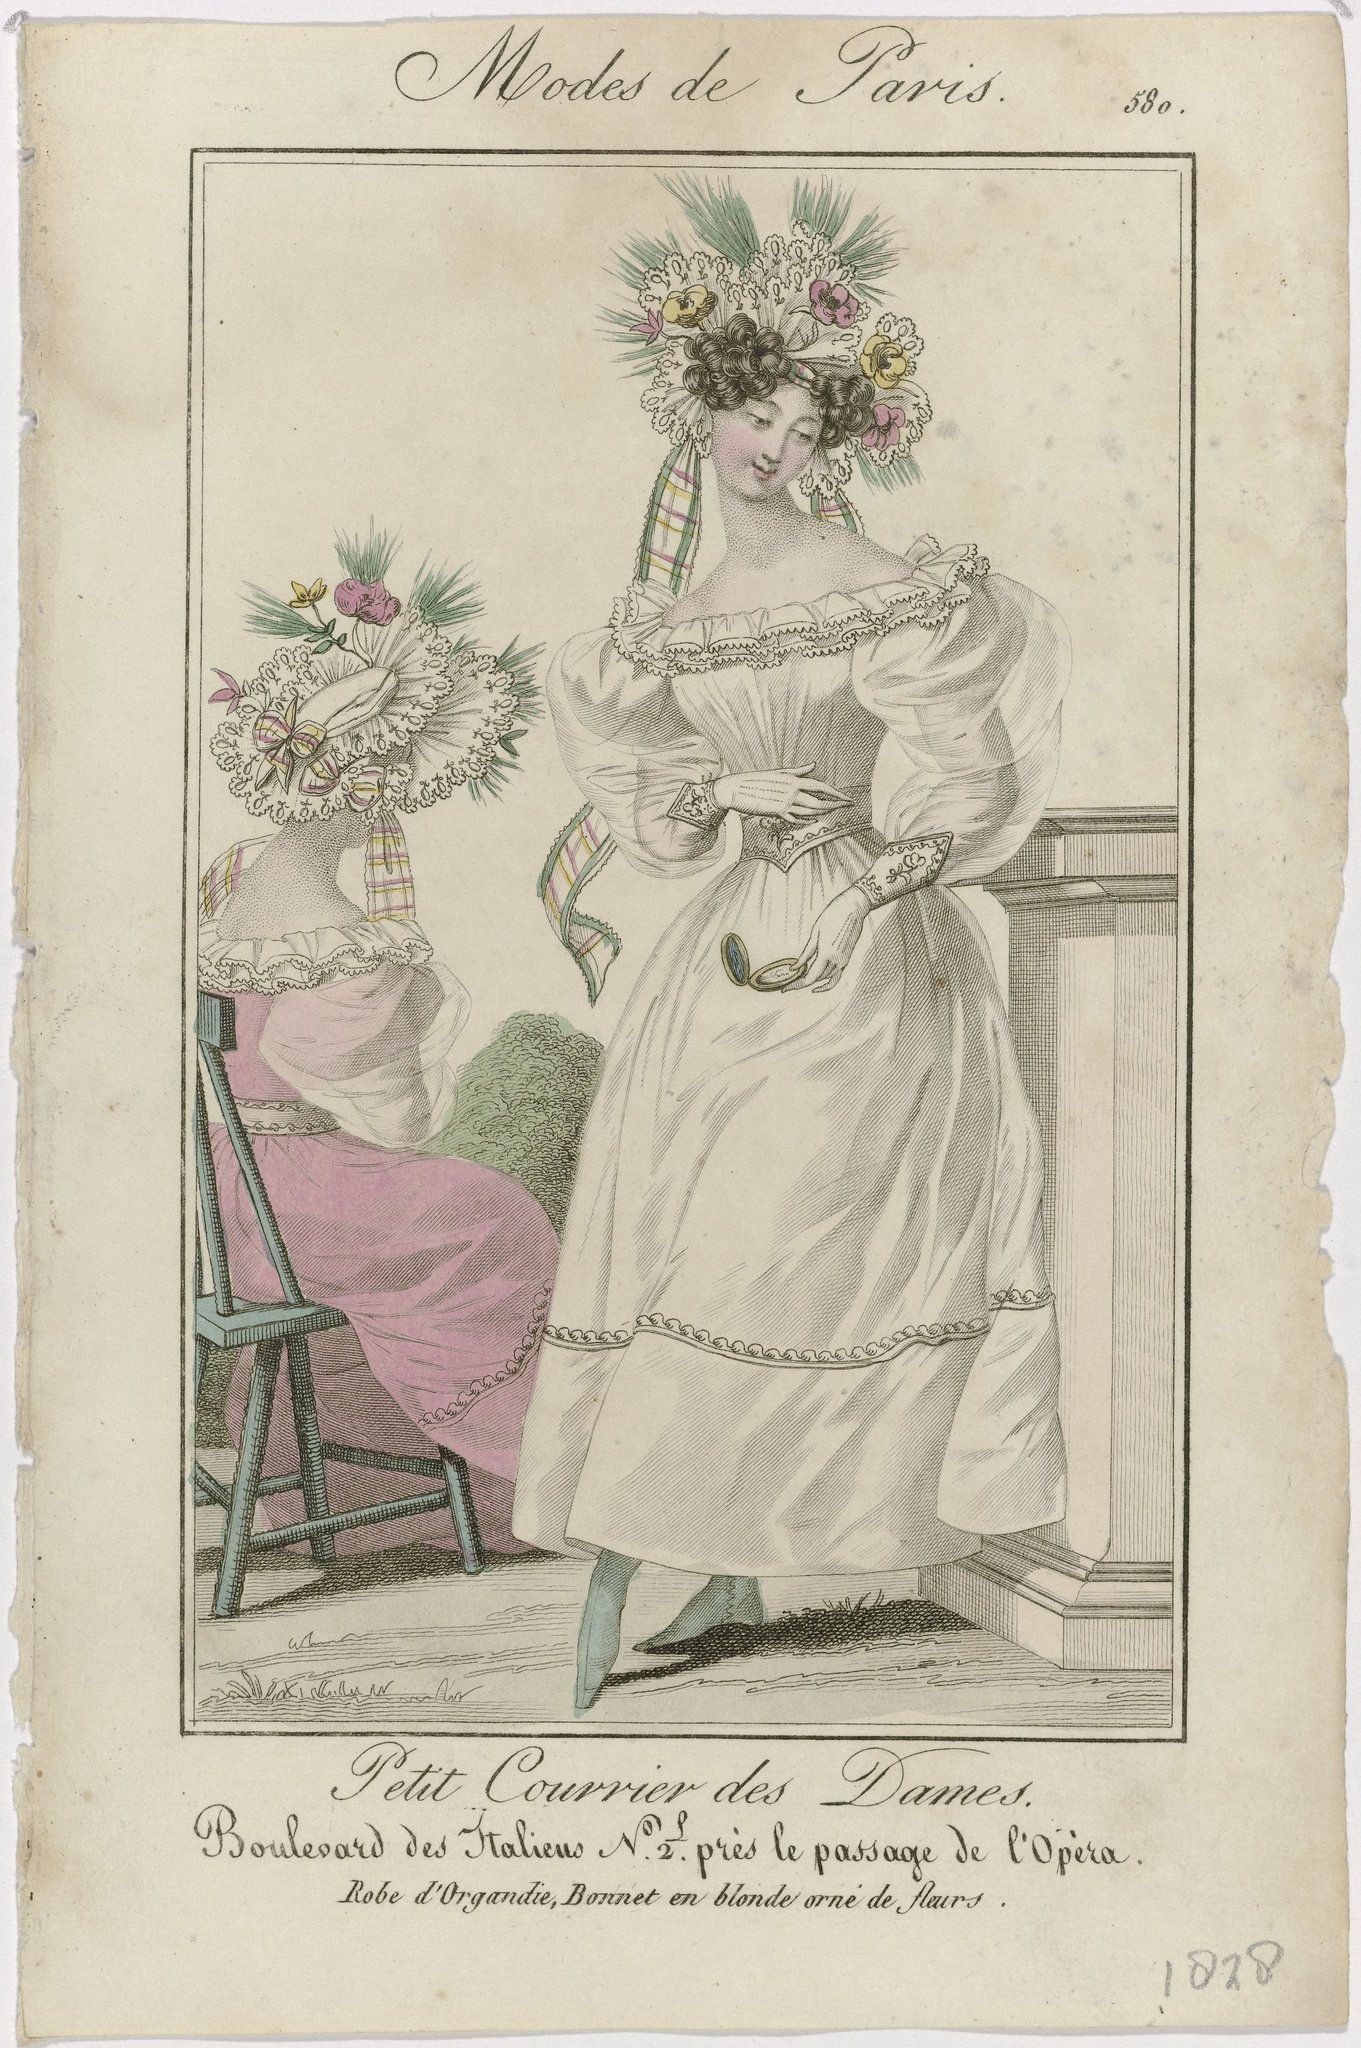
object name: fashion print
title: Petit Courrier des Dames, 1828, No. 580 : Robe d'Organdi (...)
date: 1828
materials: paper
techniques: engraving, hand coloring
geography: paris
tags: flowers, gloves, mittens (long gloves) (+ women's clothes), head-gear: cap (+ lace used for clothes), boots (+ women's clothes), head-gear: cap (+ women's clothes), fashion plates, dress, gown (+ women's clothes)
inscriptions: title: ‘Petit Courrier des Dames.’, caption: ‘Robe d'Organdie, bonnet en blonde orné de fleurs.’, title: ‘Modes de Paris.’, address: ‘Boulevard des Italiens No.2 près le passage de l'Opèra.’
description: Japon van organdie. Lange doorzichtige mouwen over korte pofmouwen. Muts van Blonde (kloskant) versierd met bloemen. Verdere accessoires: handschoenen, doosje(?), laarzen. Prent uit het modetijdschrift Petit Courrier des Dames (1821-1868).